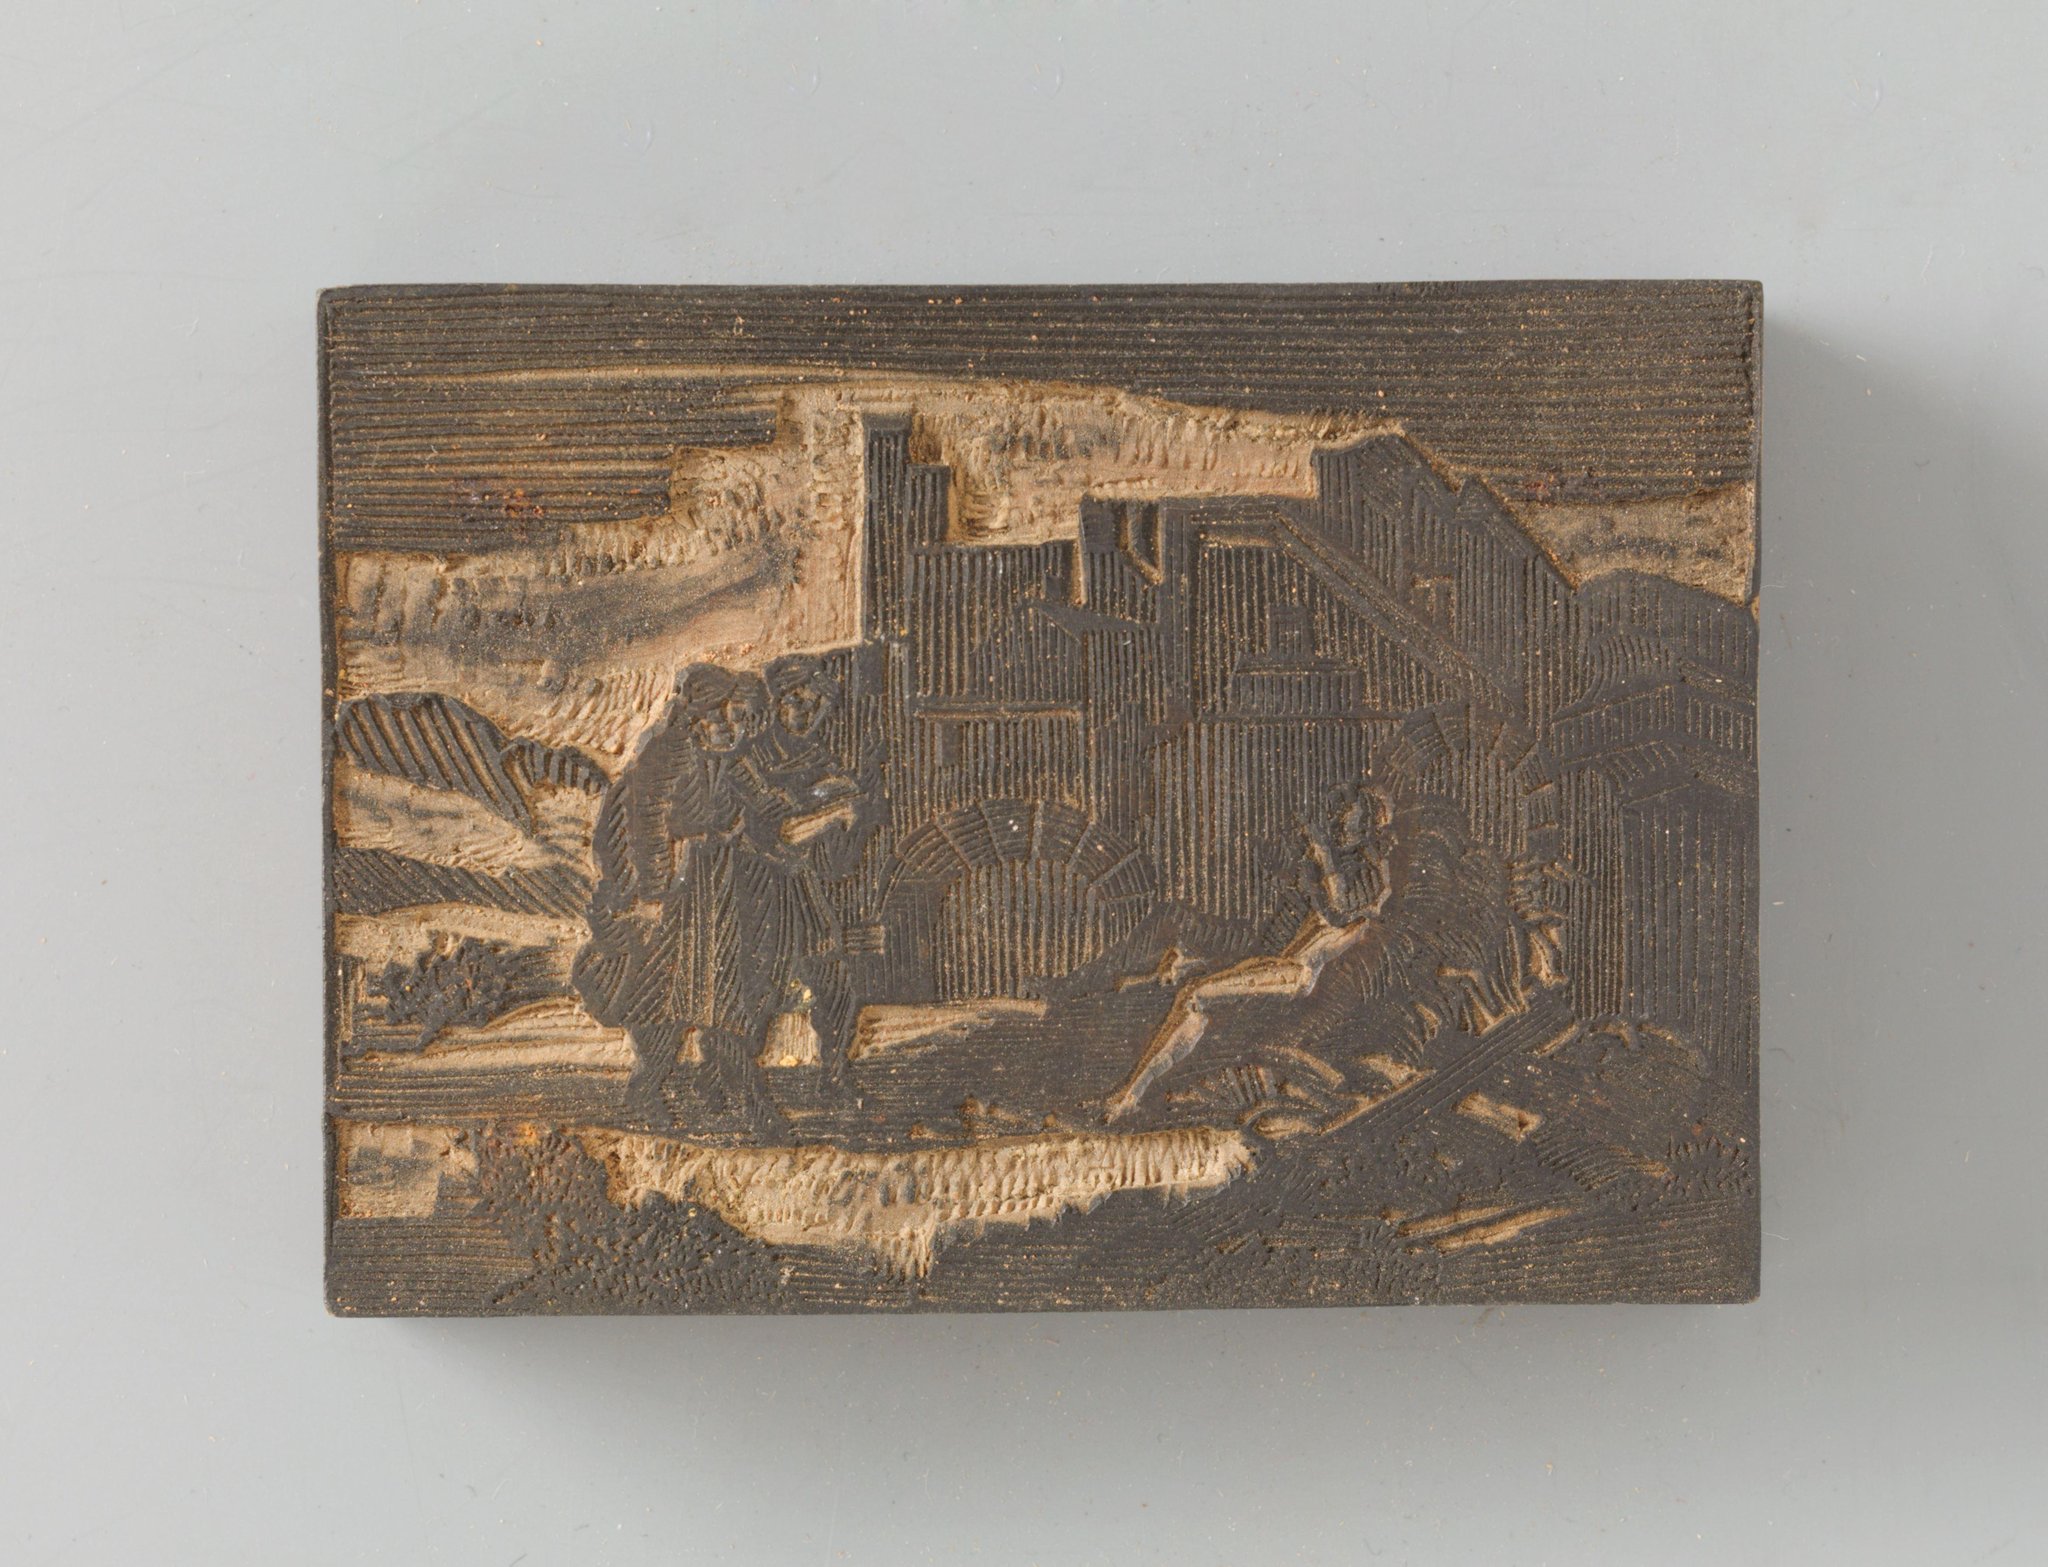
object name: wood block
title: Bijbel-illustraties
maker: Anonymous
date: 1550-1699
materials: wood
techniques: woodcut